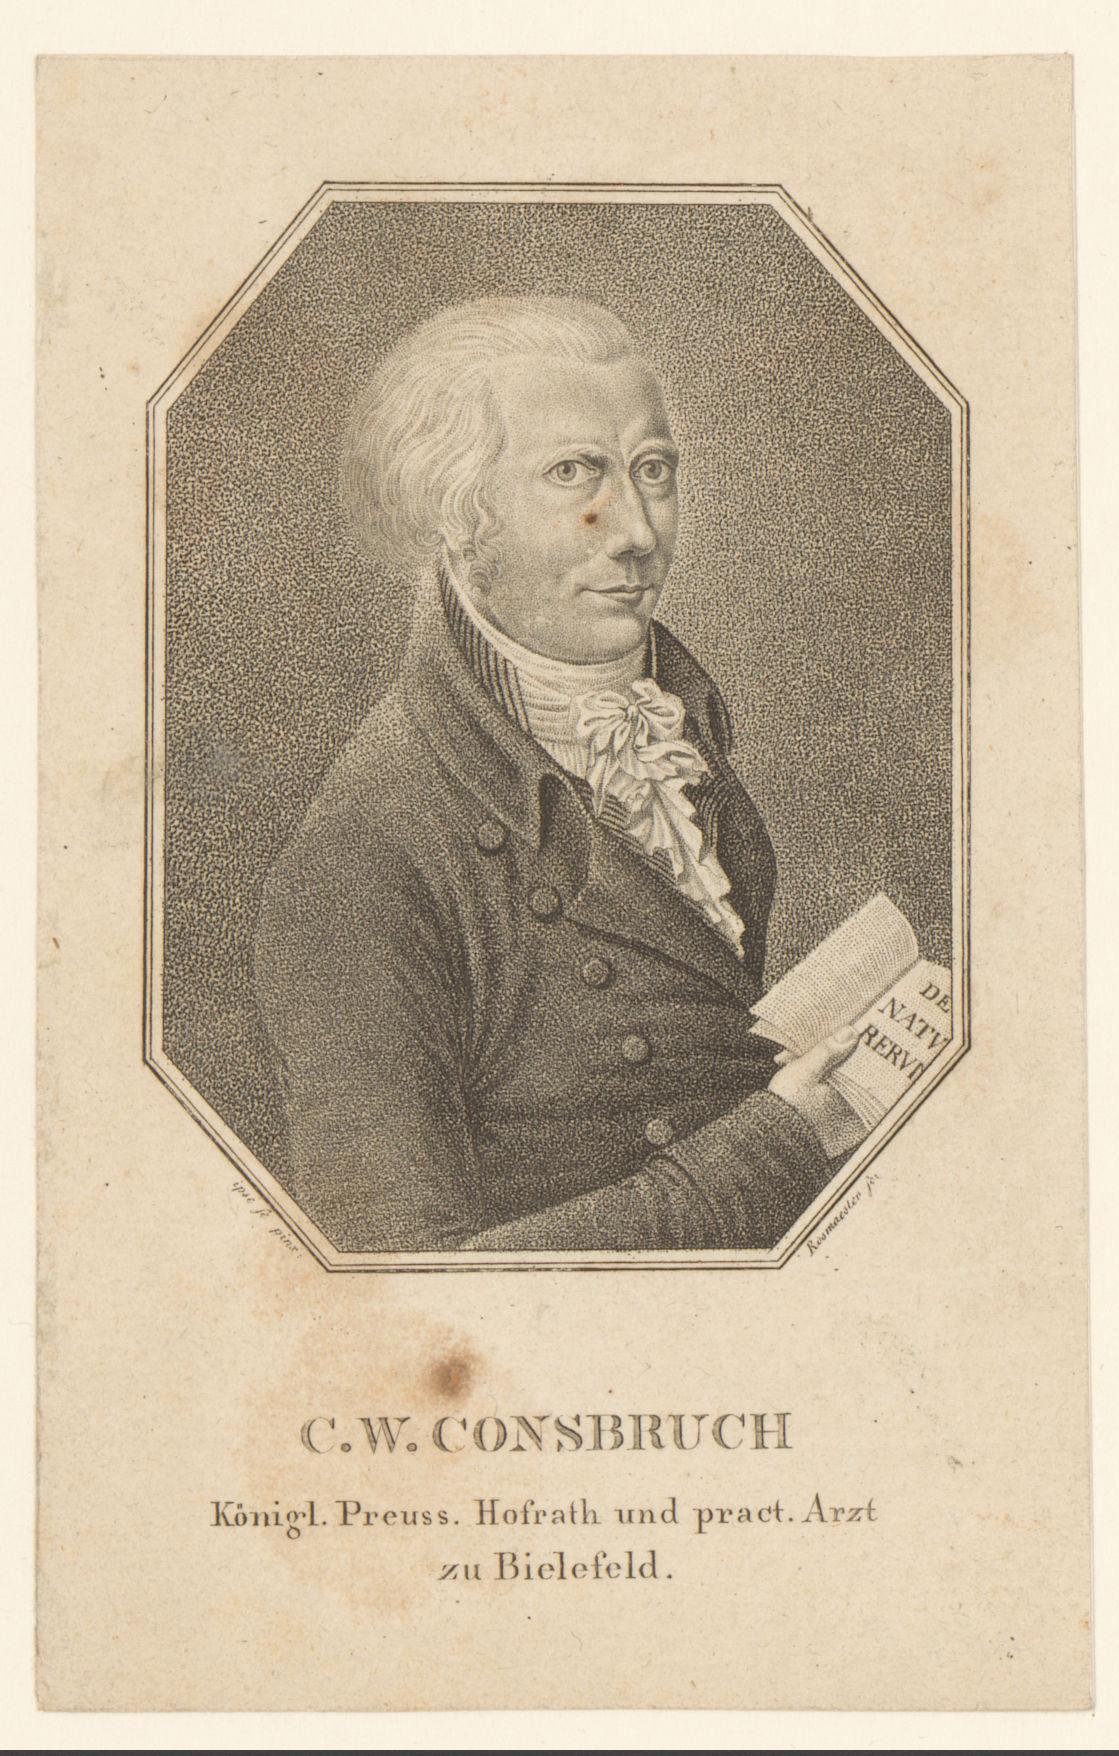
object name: print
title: Portret van Georg Wilhelm Christoph Consbruch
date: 1785-1858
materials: paper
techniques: engraving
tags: georg wilhelm christoph consbruch, historical persons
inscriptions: collector's mark: Lugt 2228